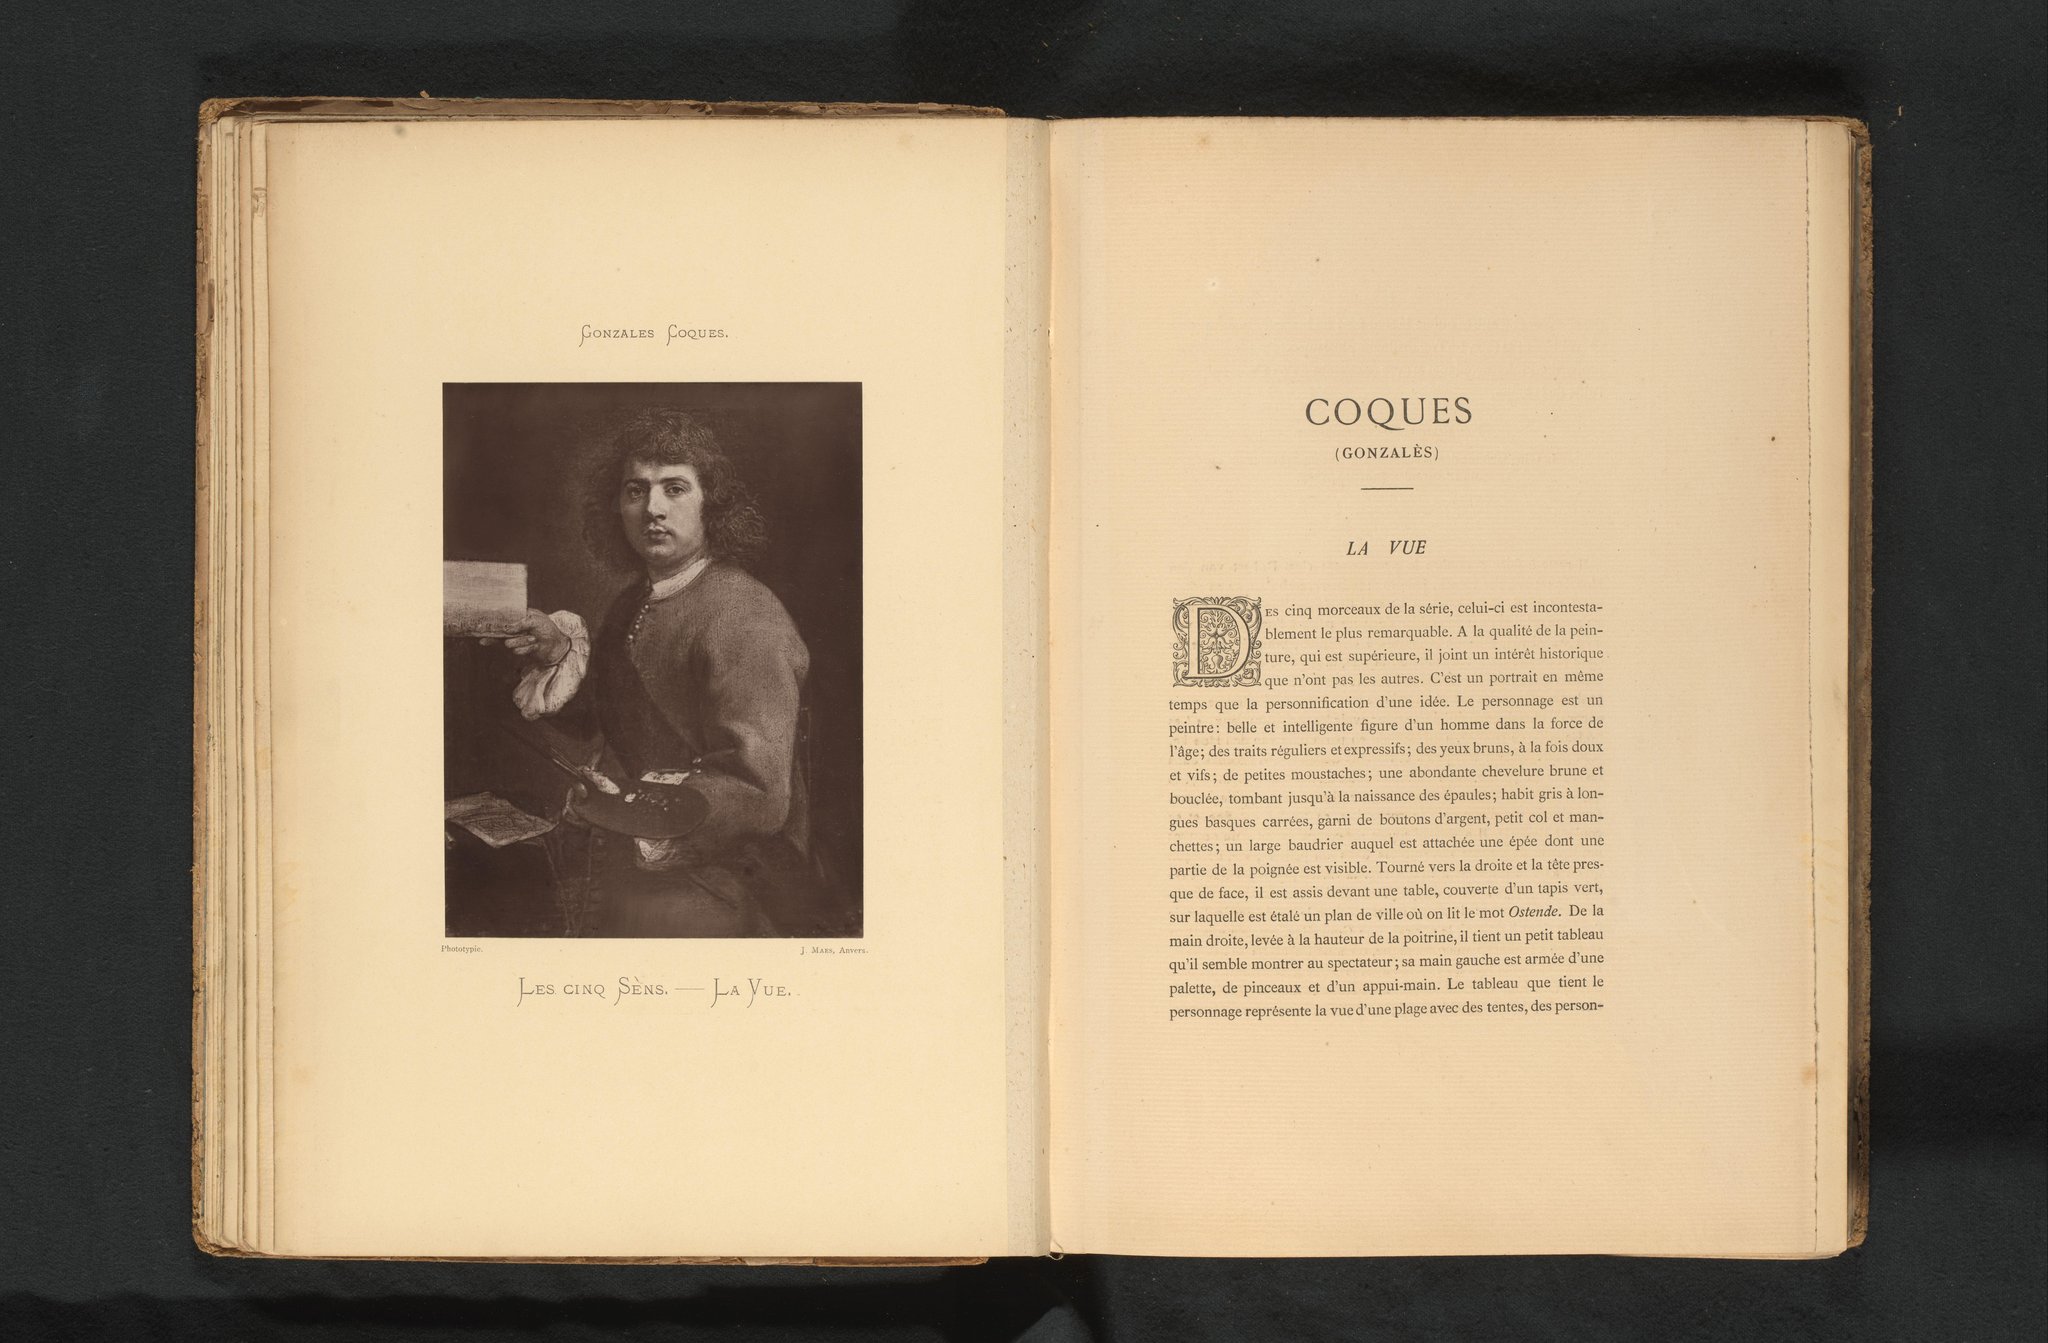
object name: reproduction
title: Les cinq Sens. - La Vue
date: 1873-1878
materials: paper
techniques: woodburytype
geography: antwerp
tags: antwerp, painter, print maker, draughtsman, robert van den hoecke, 'viso' (ripa), historical persons